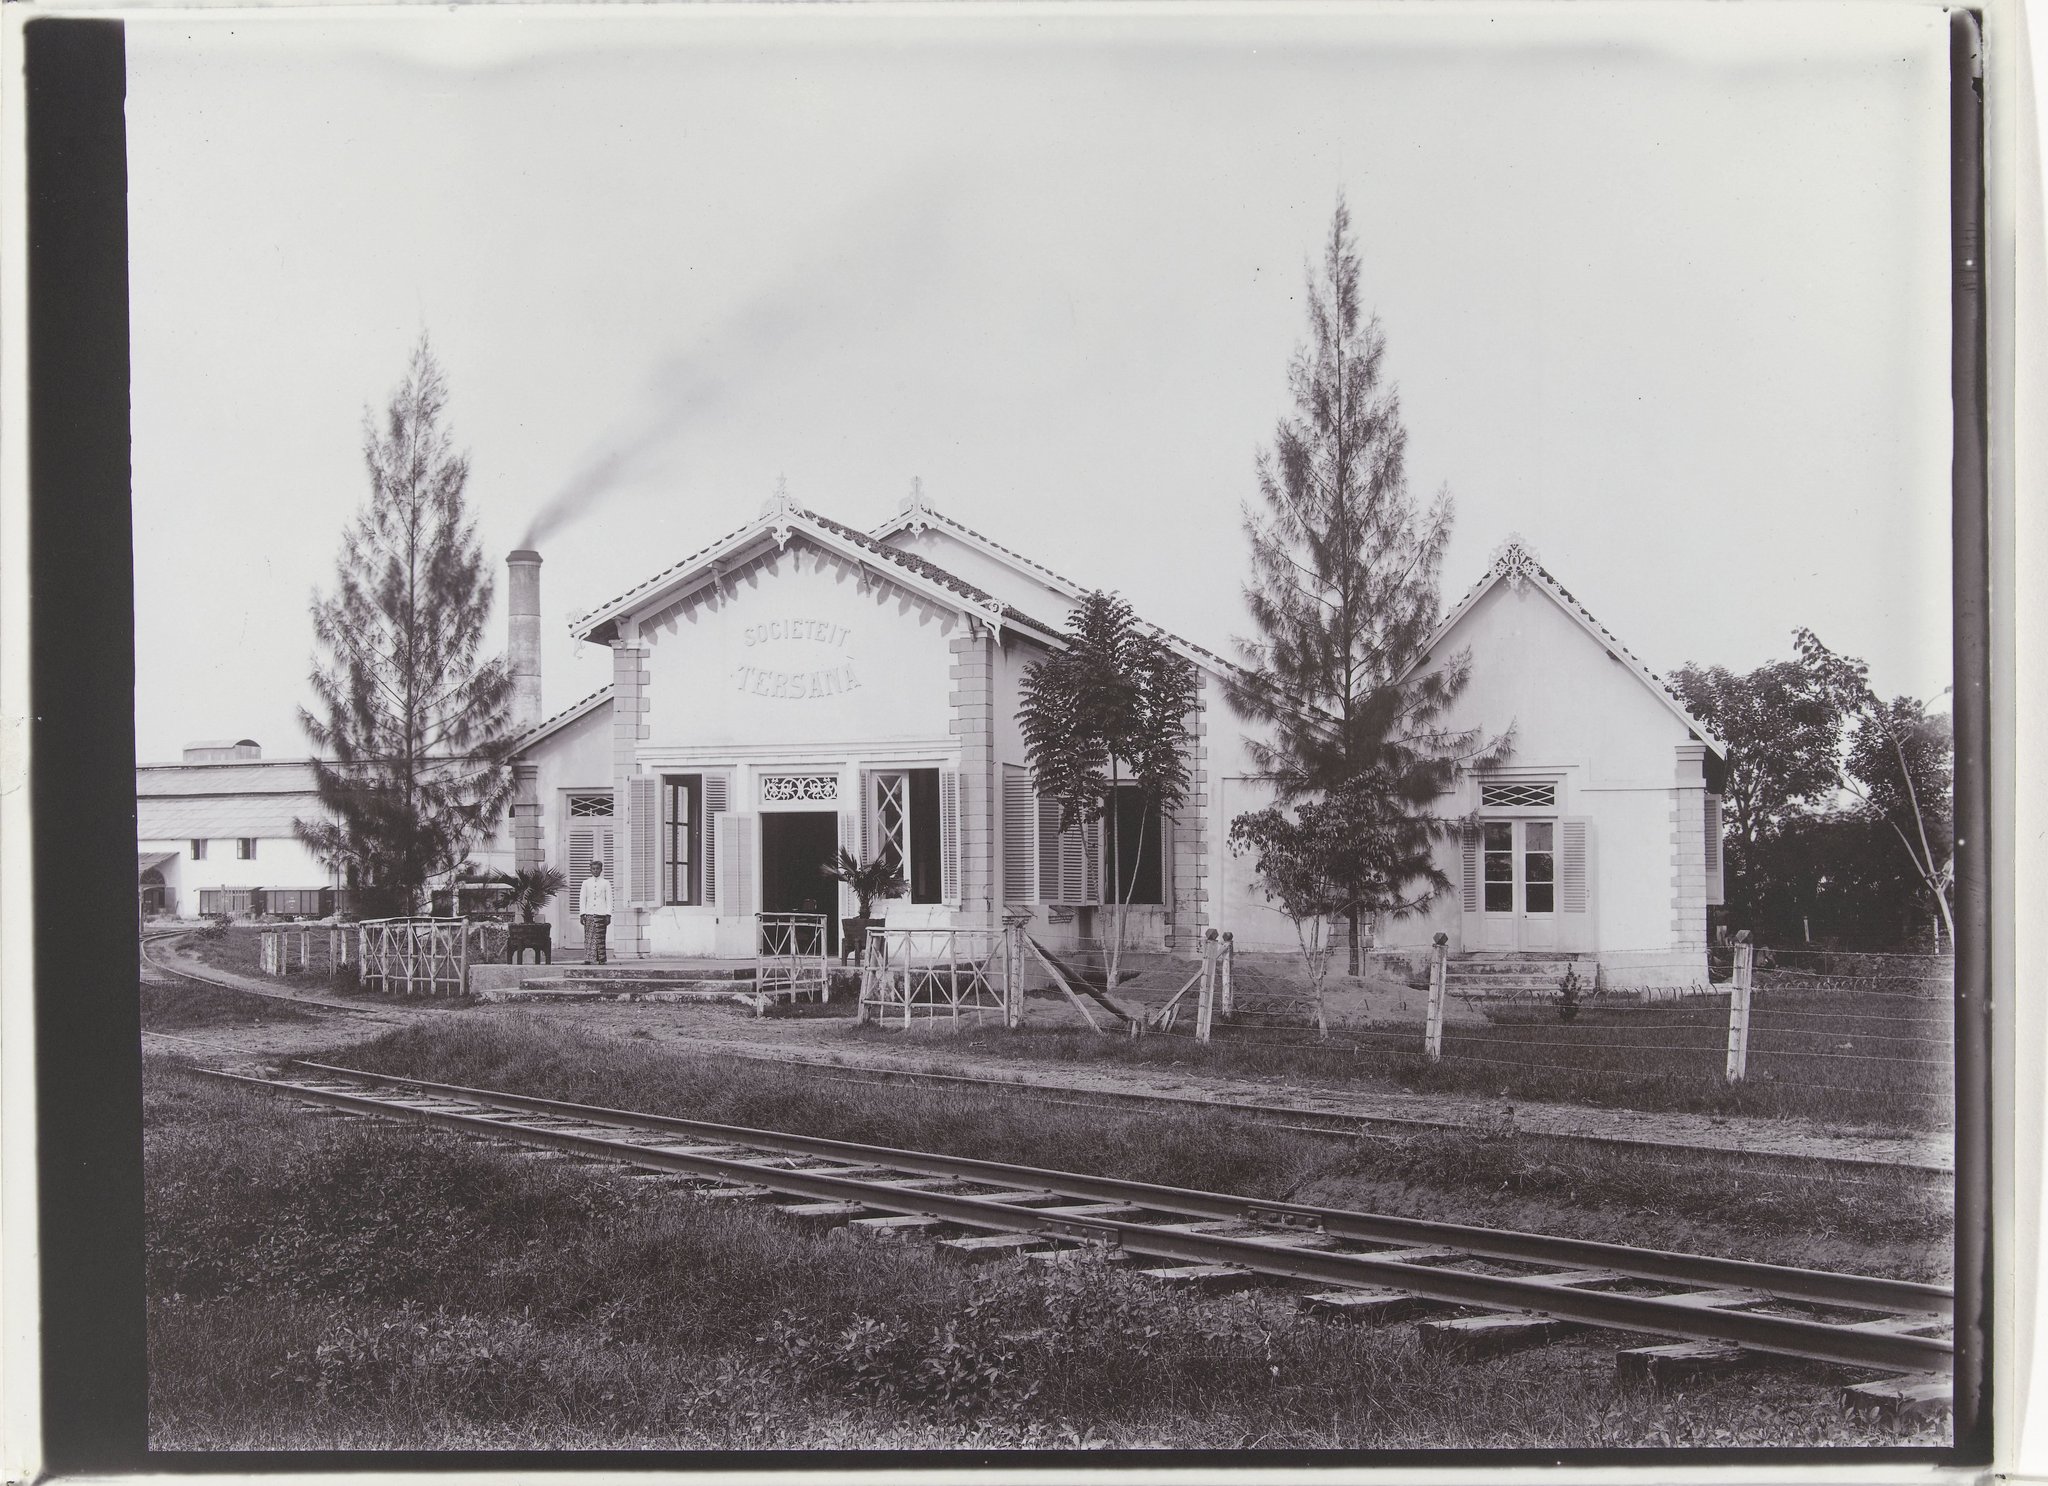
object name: photograph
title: Sociëteit Tersana op de suikeronderneming Nieuw Tersana, Cheribon, voormalig Nederlands-Indië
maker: onnes kurkdjian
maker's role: fotograaf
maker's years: 1851-1903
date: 1890-1911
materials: paper, photographic support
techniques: gelatin silver print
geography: cirebon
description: Sociëteit Tersana op de suikeronderneming Nieuw Tersana, Cheribon, voormalig Nederlands-Indië. Een bediende staat voor de ingang. Op de voorgrond de treinrails en links de schoorsteen van de fabriek.